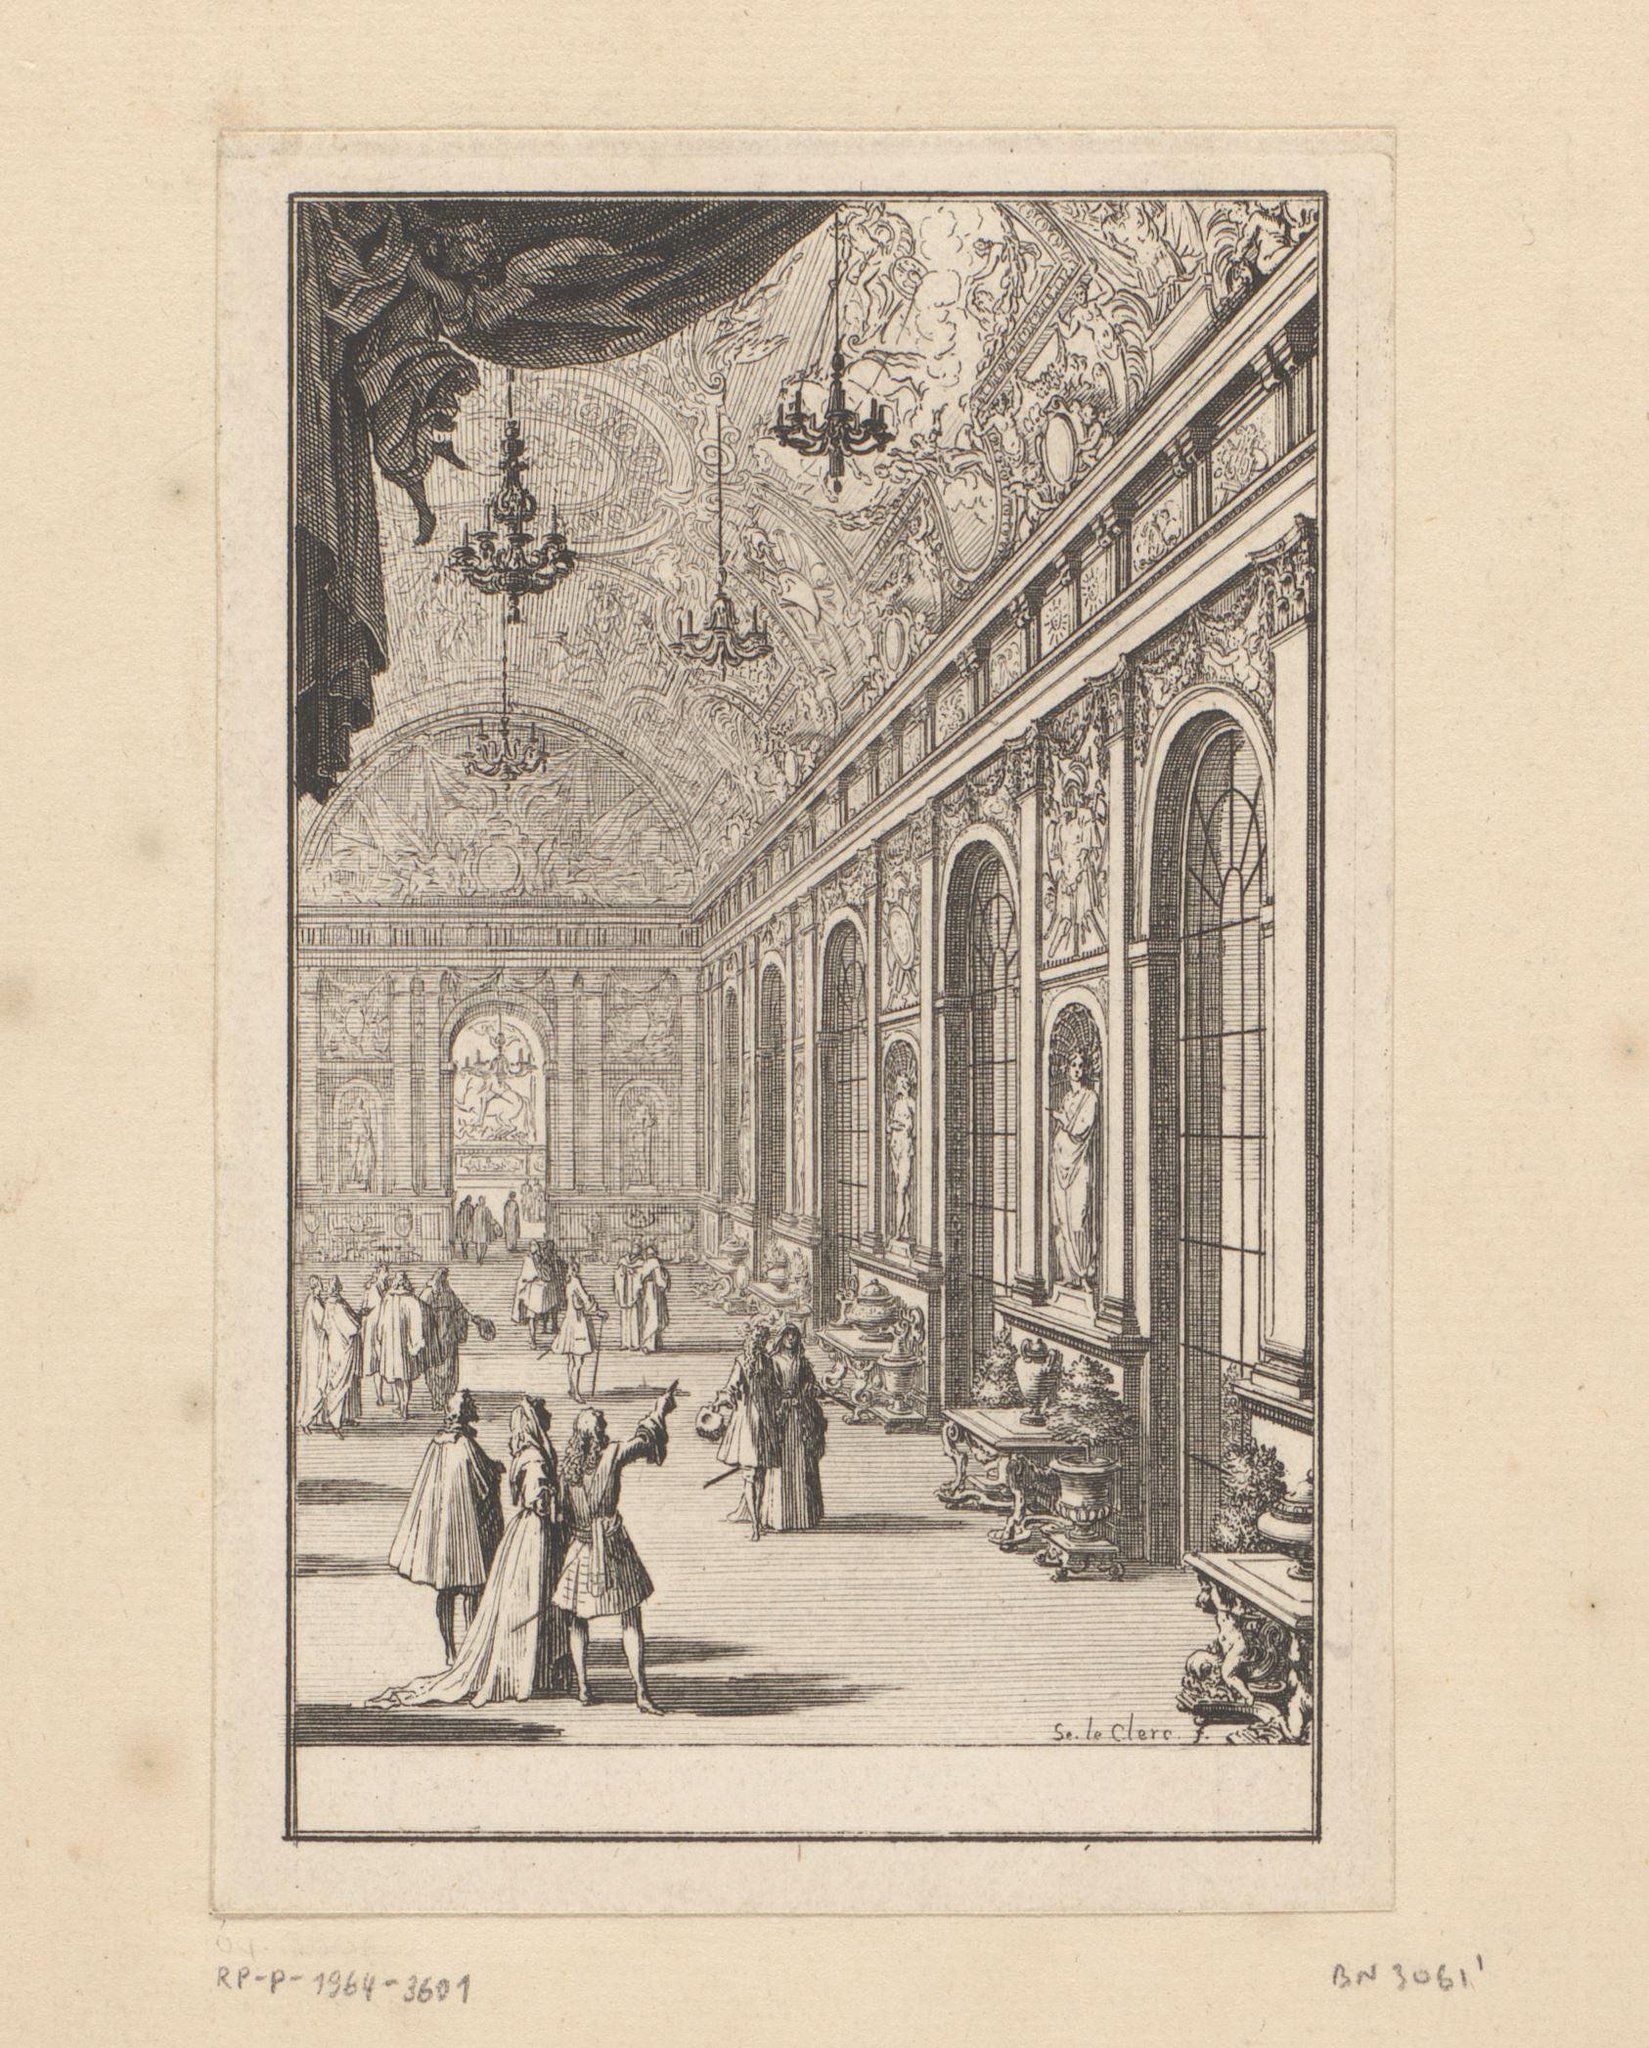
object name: print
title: Figuren in de grote zaal in het kasteel van Versailles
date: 1684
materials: paper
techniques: engraving, etching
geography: paris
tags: chandelier, candelabrum, (decorated) ceiling, other rooms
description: Prent uit: Scudéry, Madeleine de. Conservations nouvelles sur divers sujets, dédiées au Roy. Parijs: Claude Barbin, 1684.